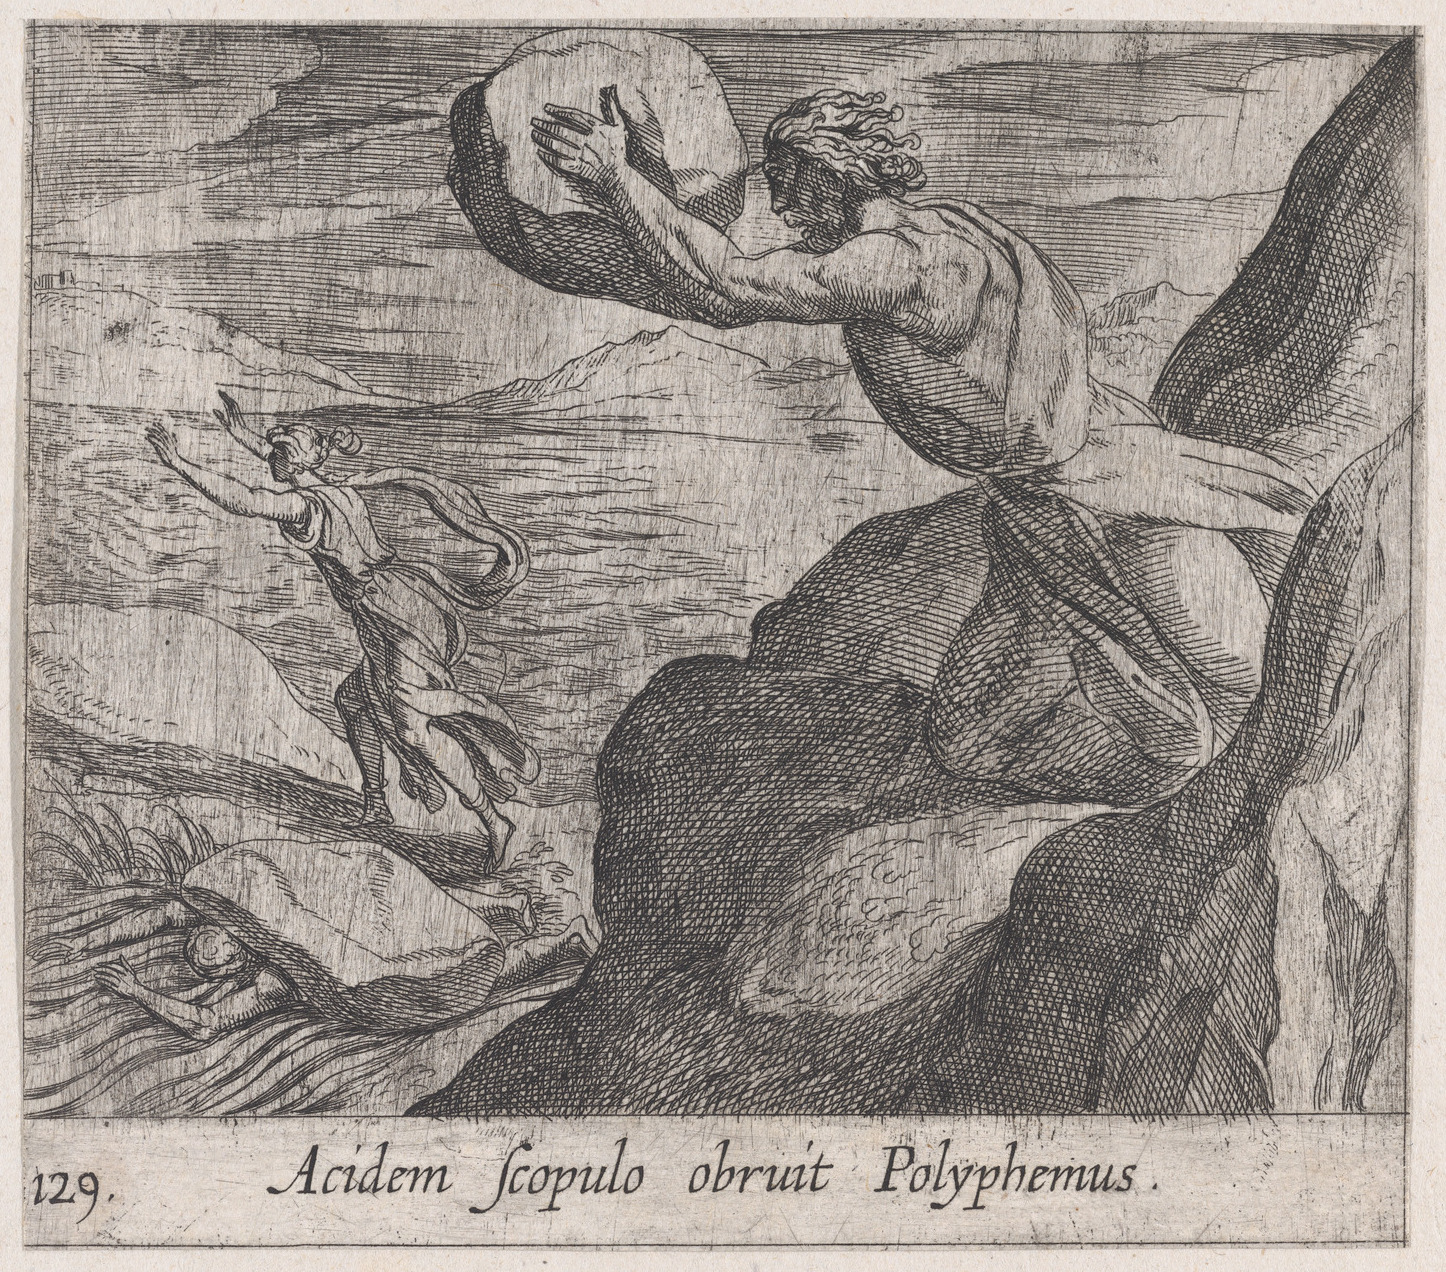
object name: print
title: Plate 129: Acis Killed by Polyphemus (Acidem Scolpulo orbruit Polyphemus), from Ovid's 'Metamorphoses'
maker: antonio tempesta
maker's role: artist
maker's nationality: italian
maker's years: 1555-1630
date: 1606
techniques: etching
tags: men,women